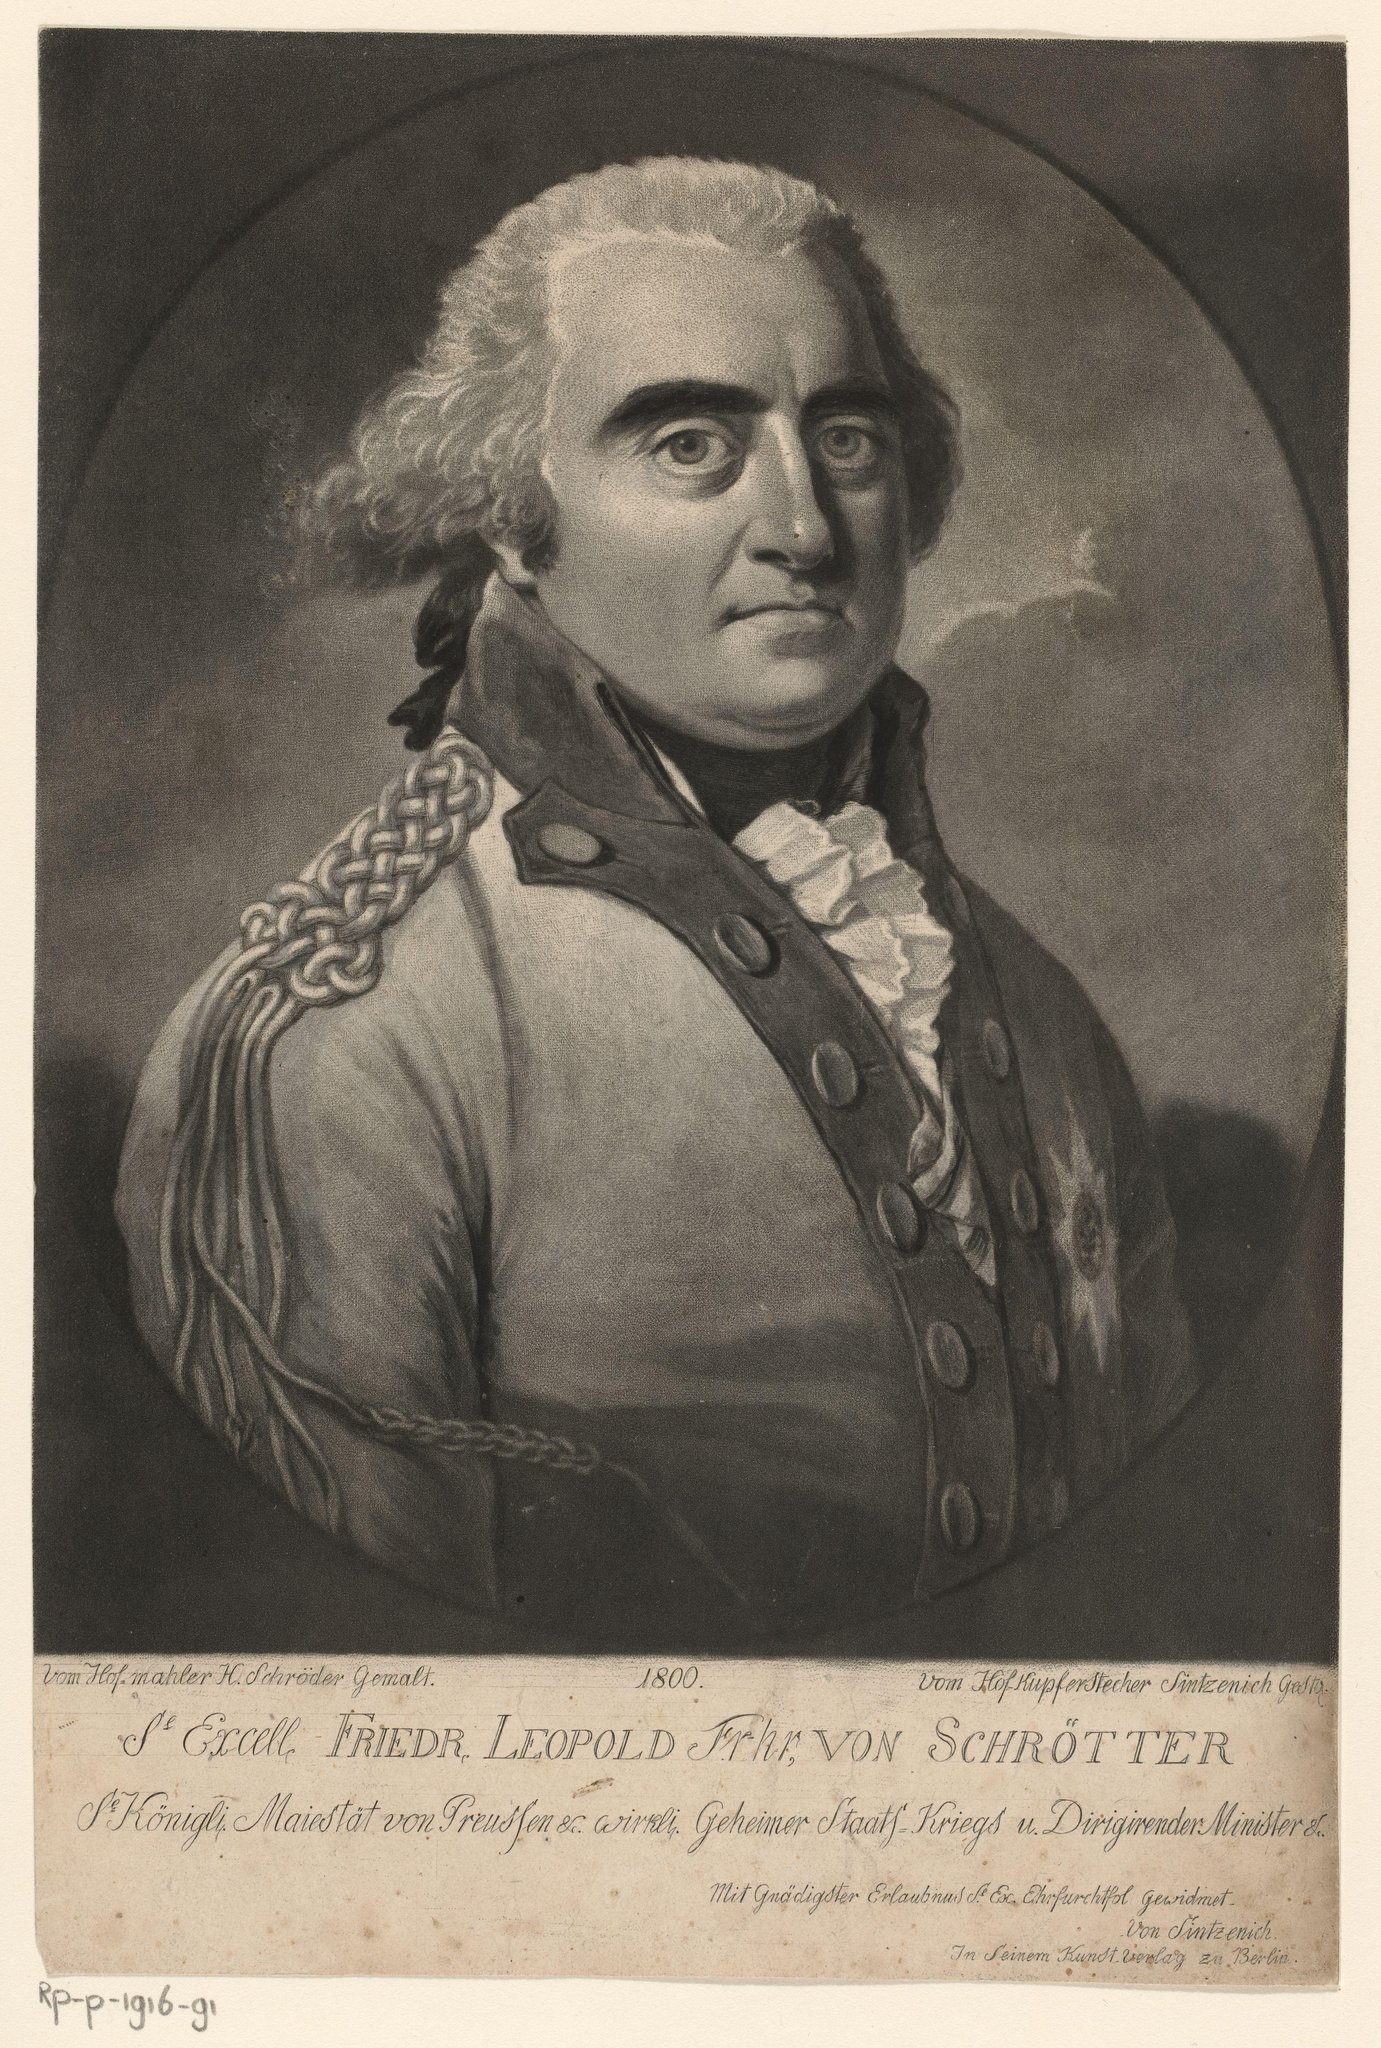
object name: print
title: Portret van Friedrich Leopold Freiherr von Schrötter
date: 1800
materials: paper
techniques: mezzotint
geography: berlin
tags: berlin, knighthood order, historical persons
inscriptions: collector's mark: Lugt 2228